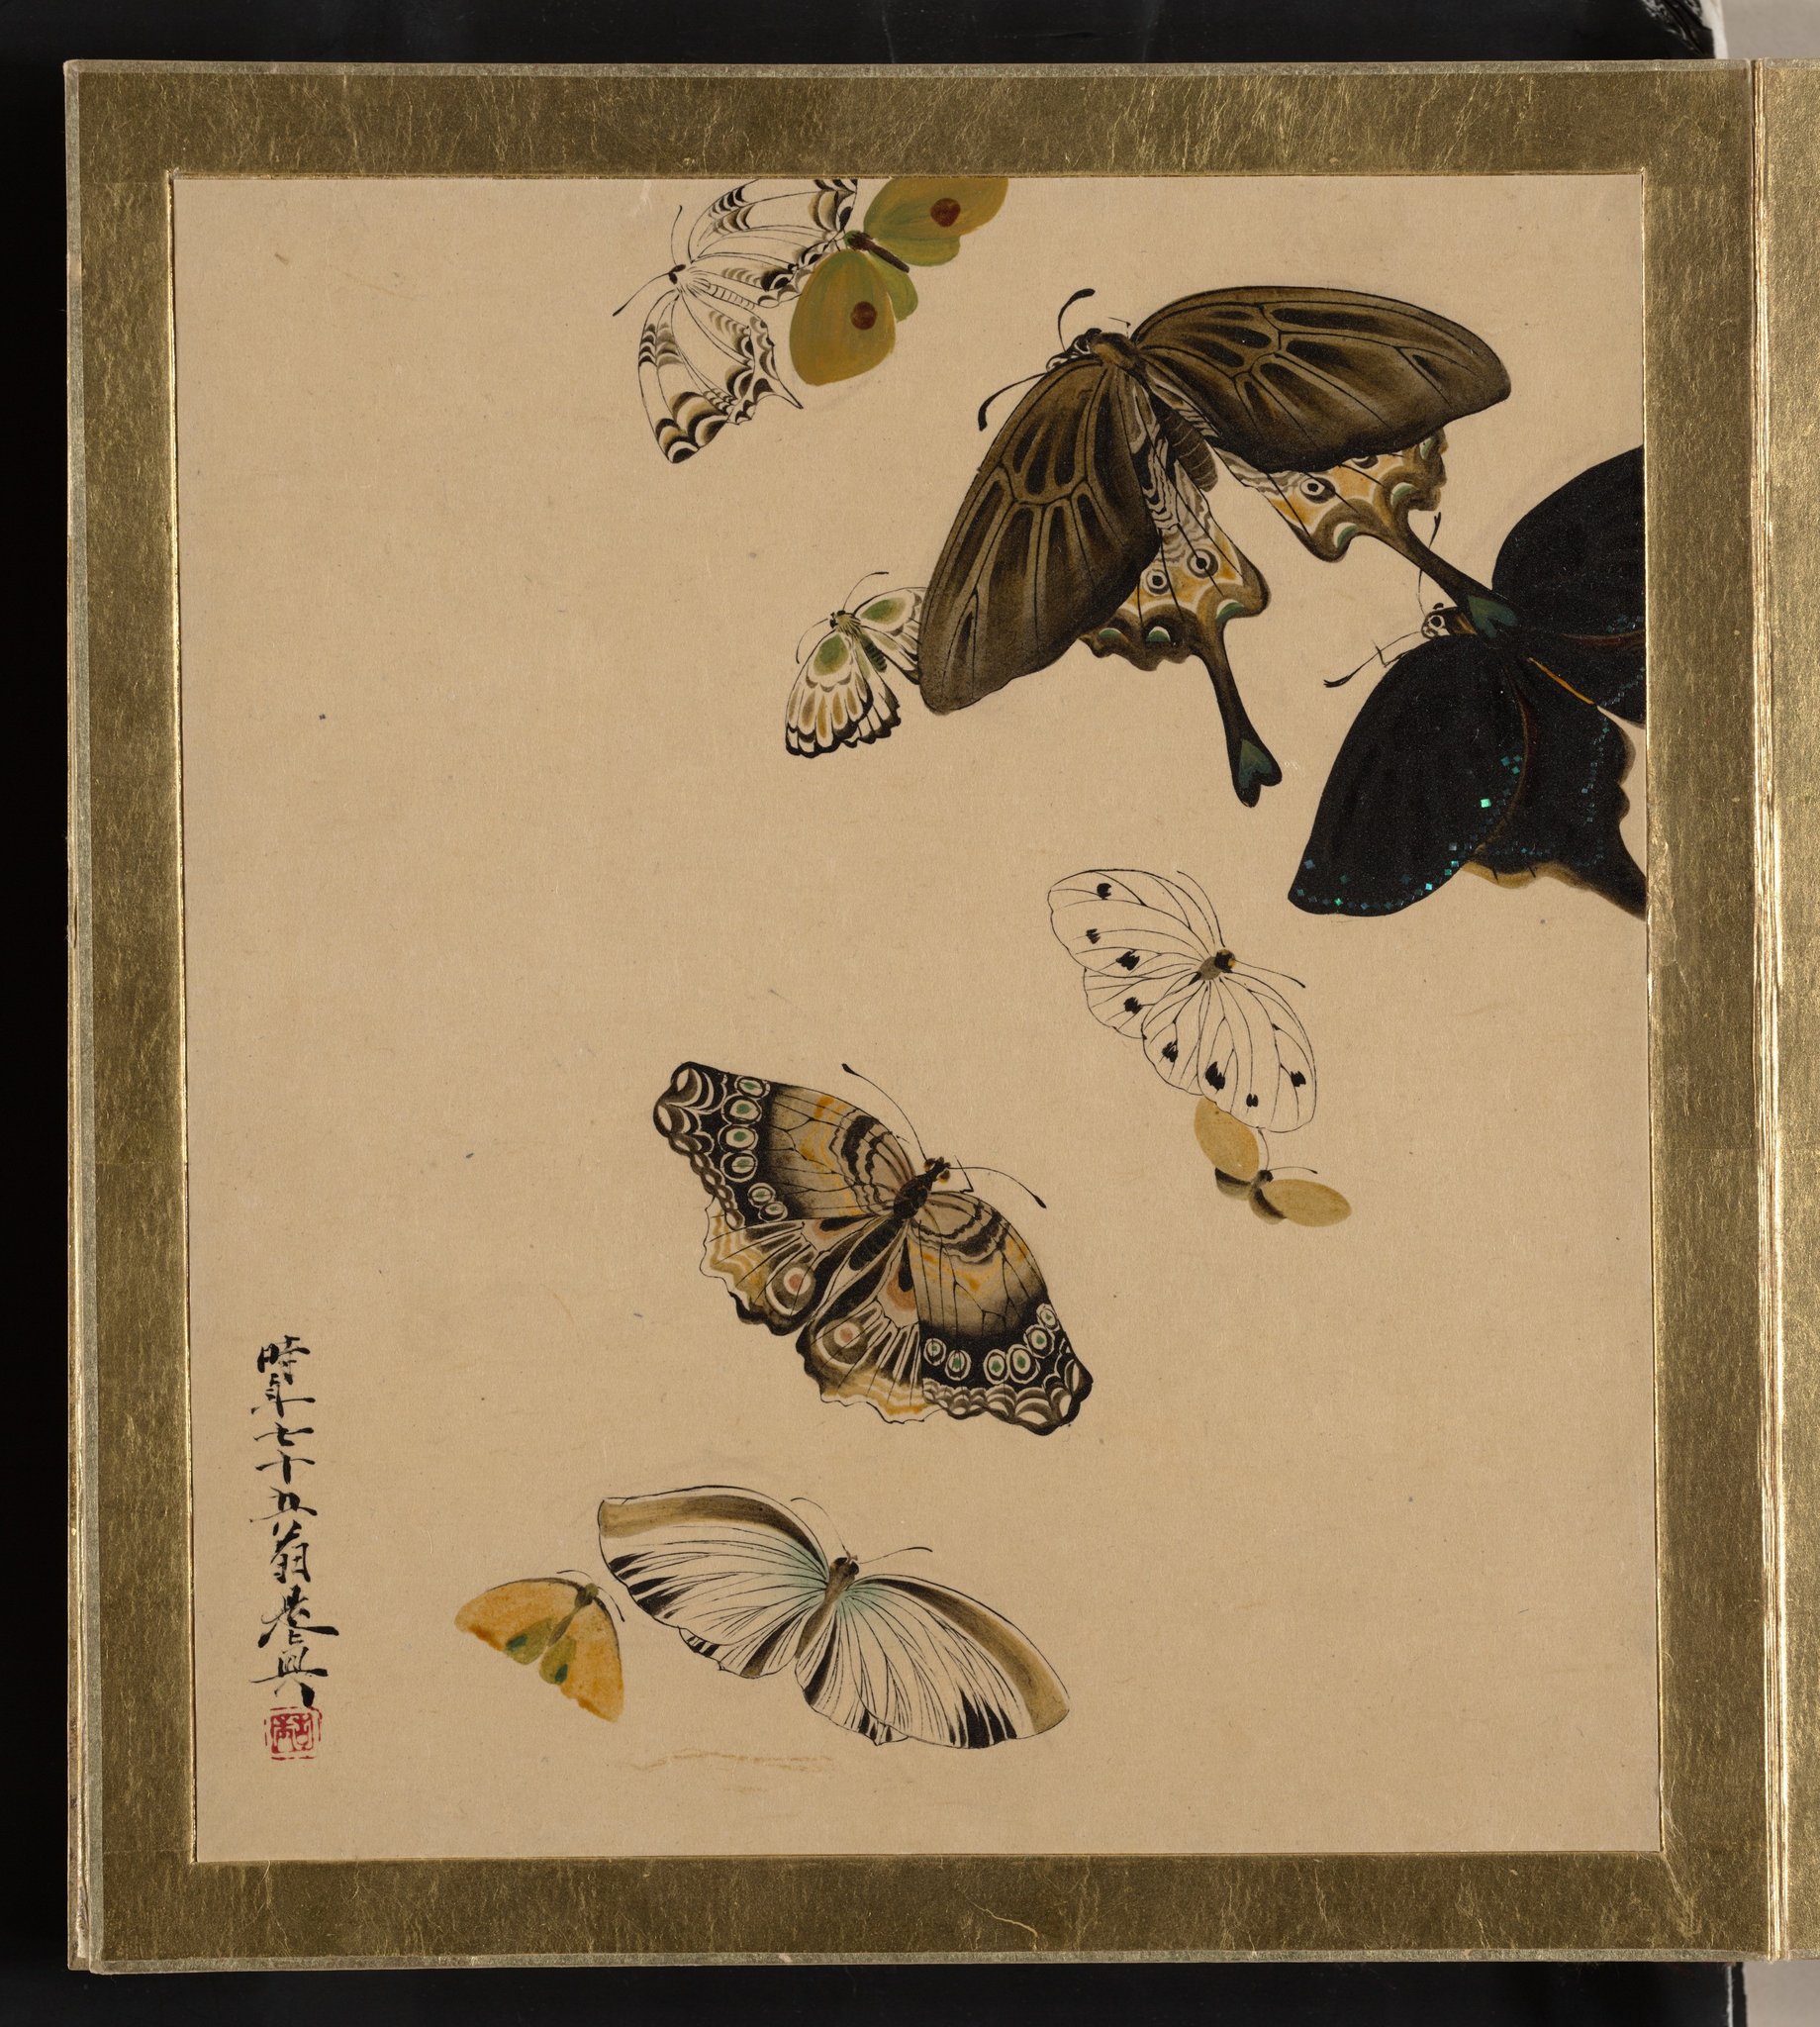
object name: painting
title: Lacquer Paintings of Various Subjects: Butterflies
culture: japanese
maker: shibata zeshin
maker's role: artist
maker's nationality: japanese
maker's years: 1807-1891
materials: lacquer, mother of pearl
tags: butterflies